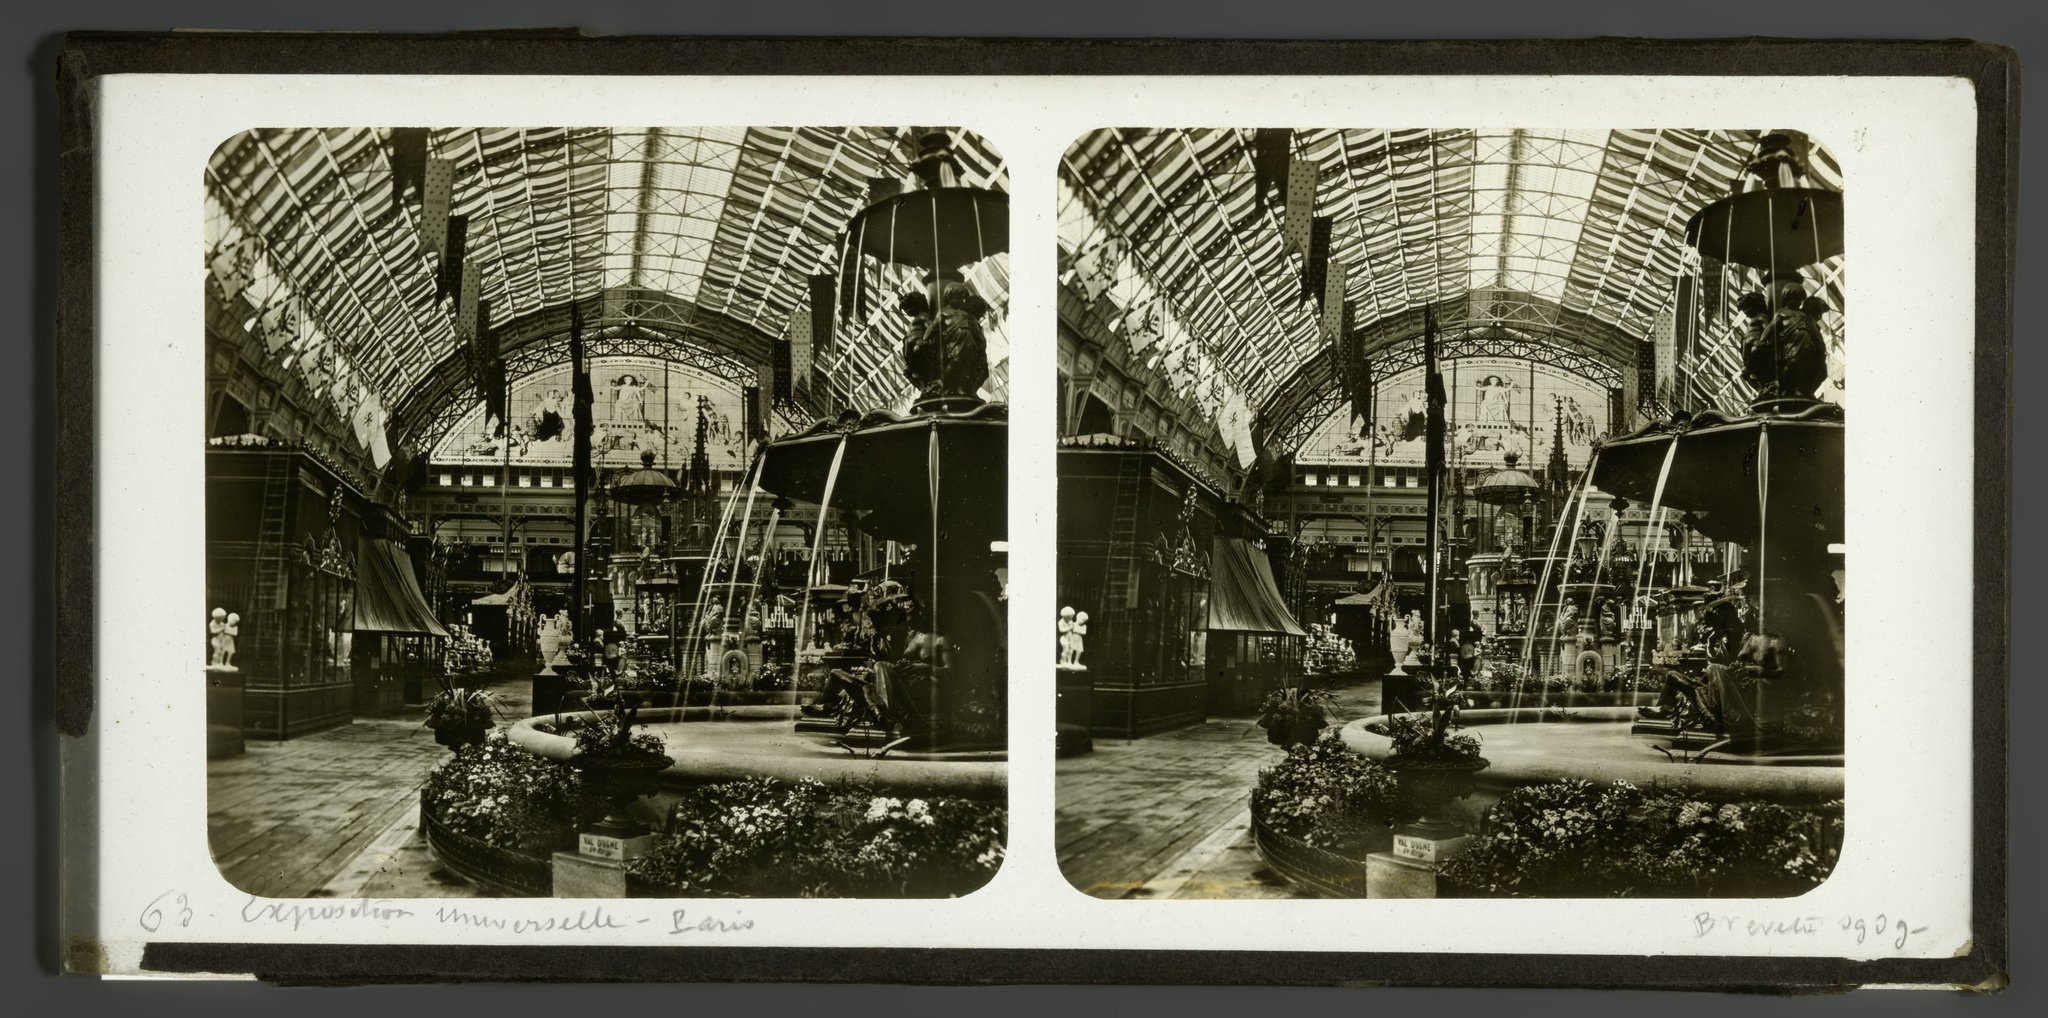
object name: stereoscopic photograph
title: Expositie op de Wereldtentoonstelling van 1855 te Parijs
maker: Anonymous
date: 1856-1866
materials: glass, paper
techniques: slide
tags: world fair, world exhibition, paris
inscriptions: annotation: ‘63. Exposition universell - Paris/ Breveté s.g.d.g.’